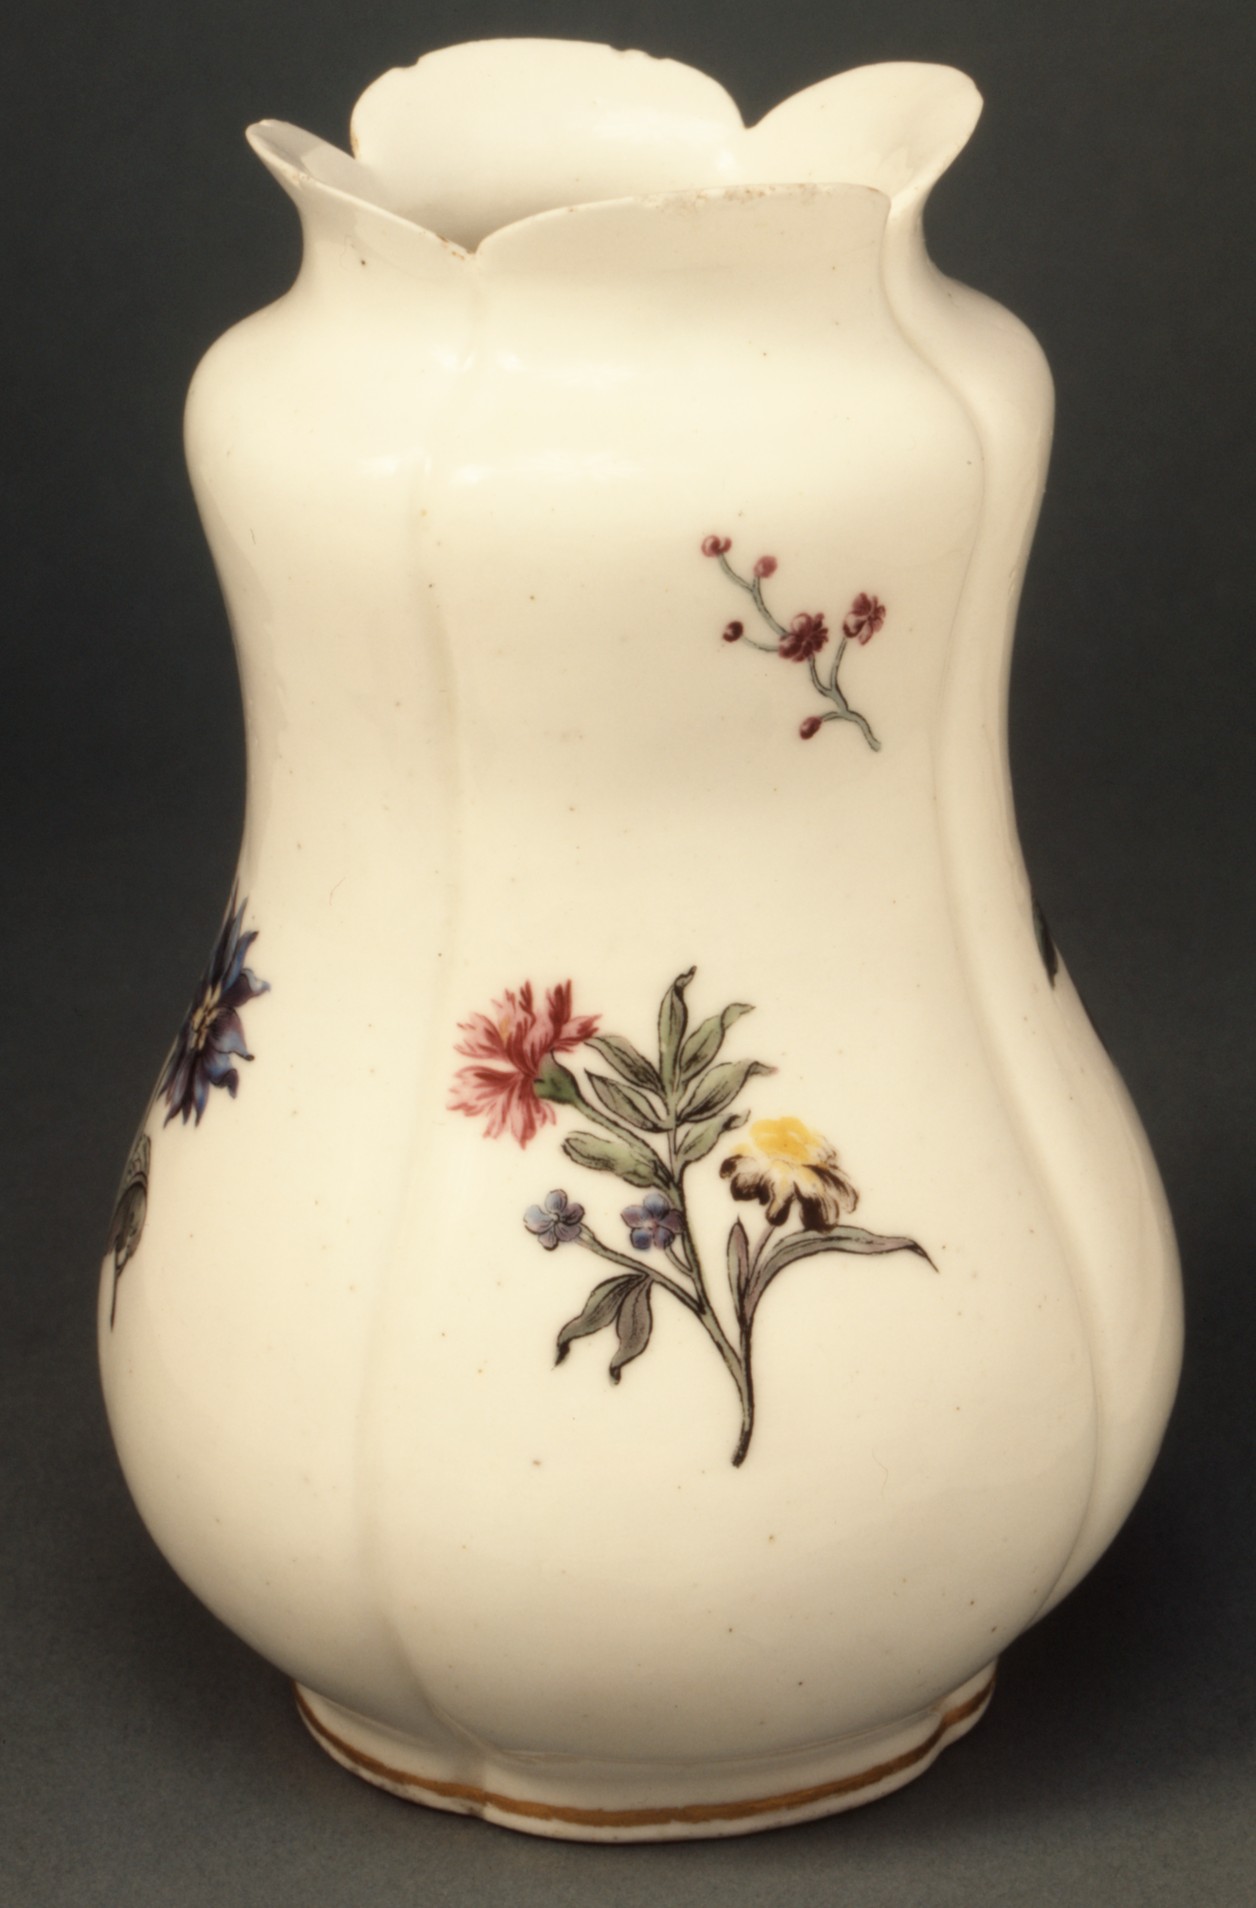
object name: vase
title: Vase (pot à fleurs)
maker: vincennes manufactory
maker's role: manufactory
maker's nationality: french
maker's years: 1740-1756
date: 1749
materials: soft paste porcelain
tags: flowers